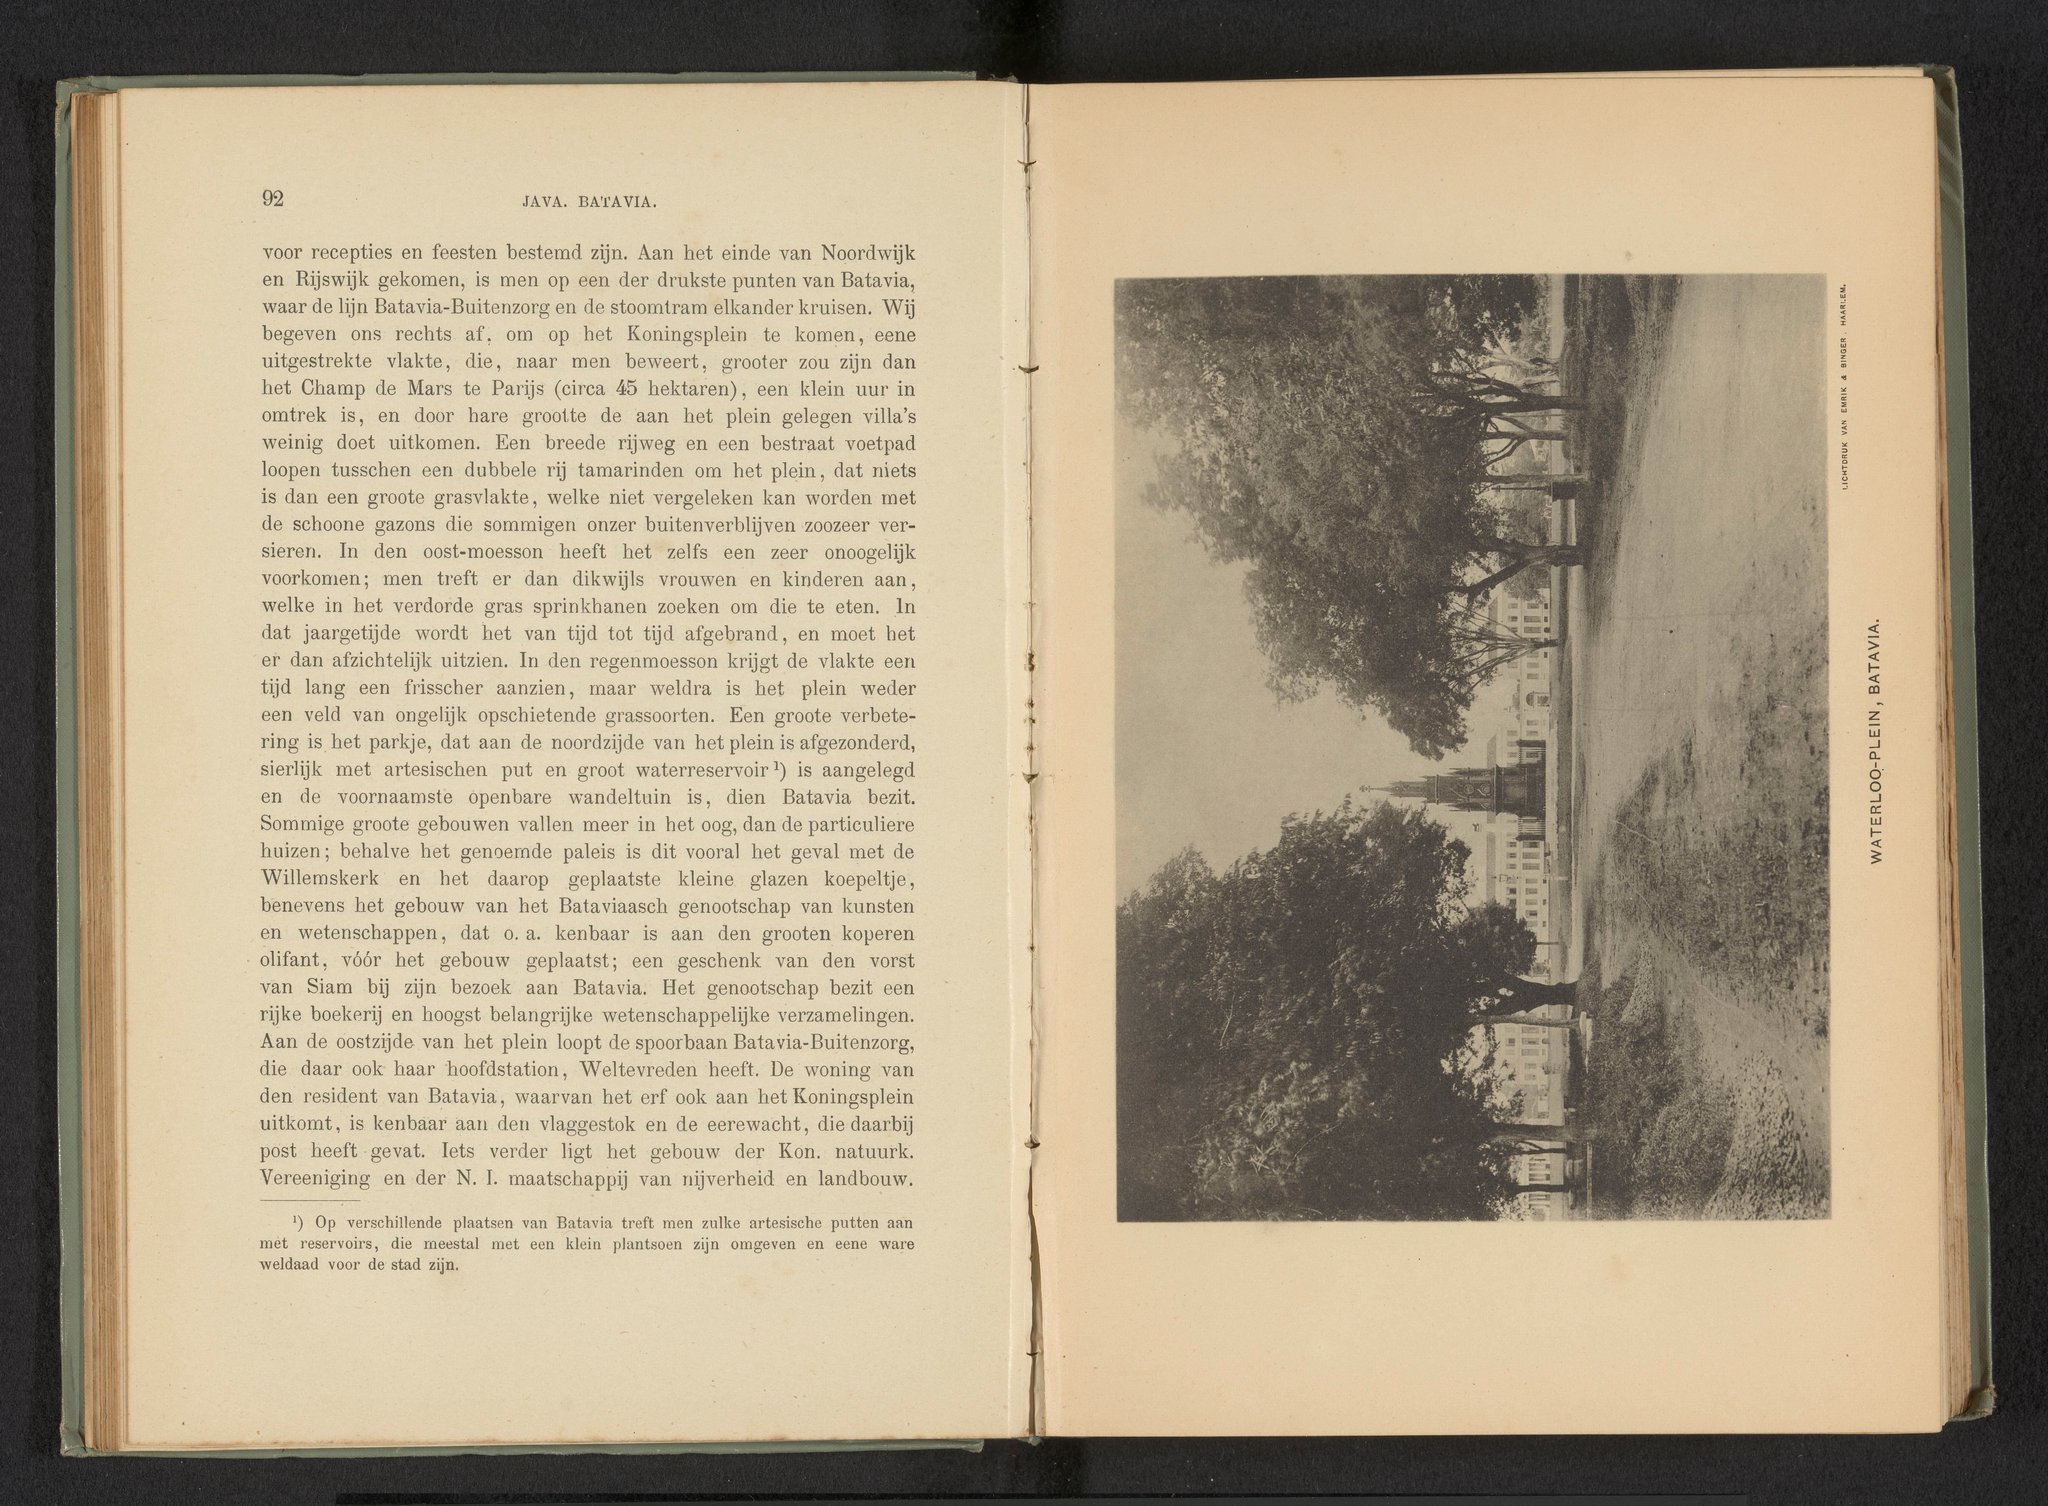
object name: page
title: Waterloo-plein, Batavia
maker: Anonymous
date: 1883-1894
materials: paper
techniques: photograph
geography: haarlem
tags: square, place, circus, etc., monument, statue